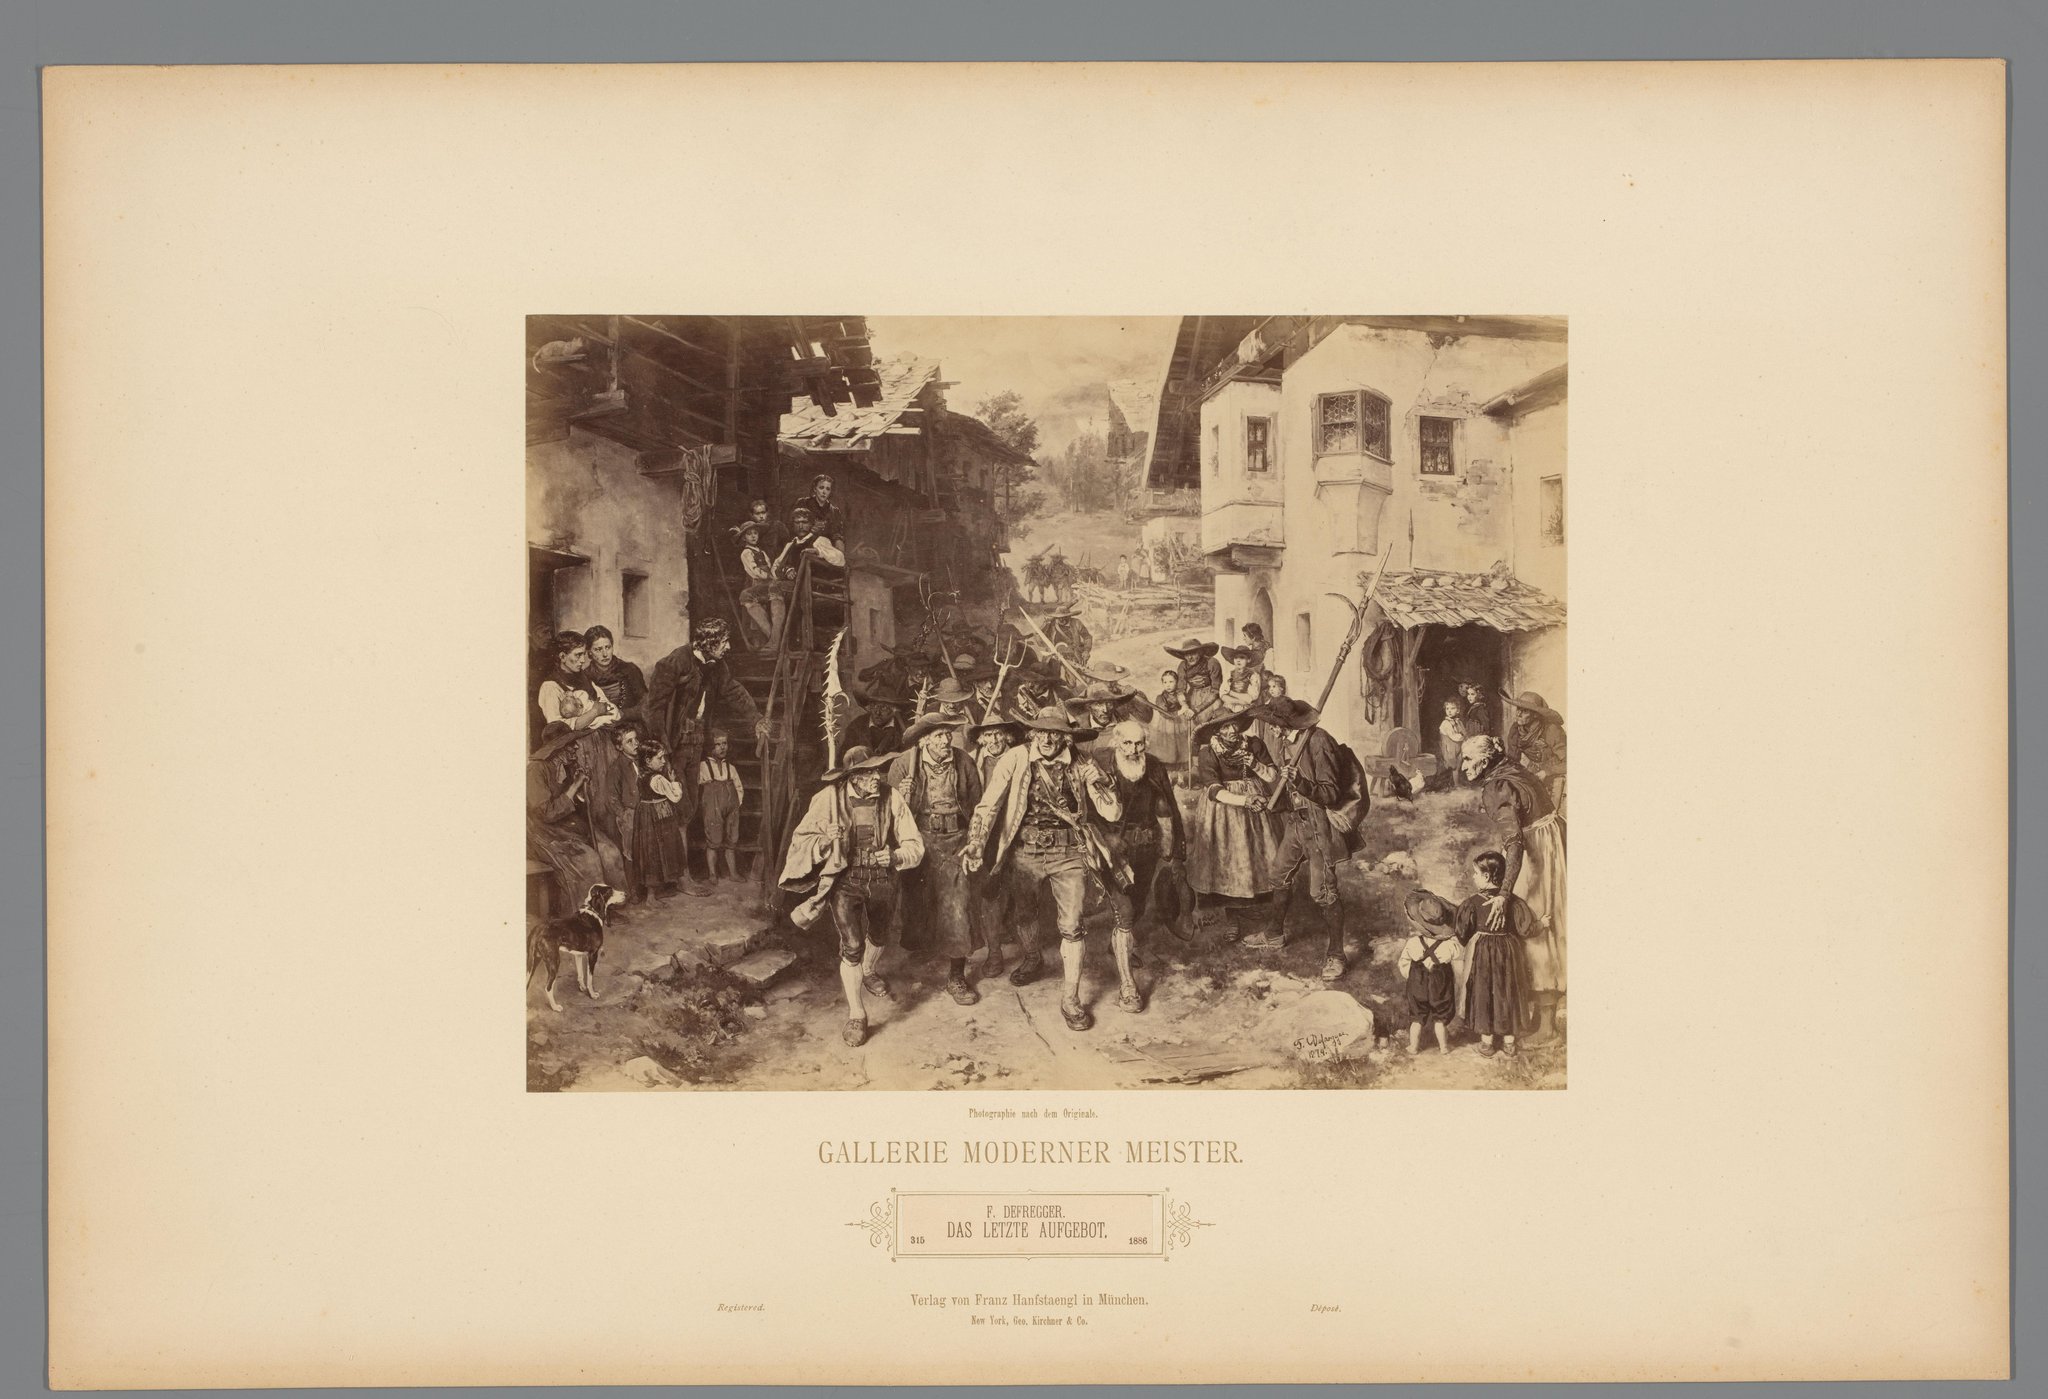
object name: photograph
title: Fotoreproductie van Das Letzte Aufgebot door Franz von Defregger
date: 1886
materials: cardboard, photographic support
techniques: albumen print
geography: new york city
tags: army 'en route'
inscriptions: inscription: ‘F. DEGREFFER/ DAS LETZTE AUFGEBOT./ 315 - 1886’, inscription: ‘Photographie nach dem Originale.’, inscription: ‘Registered. - Déposé.’